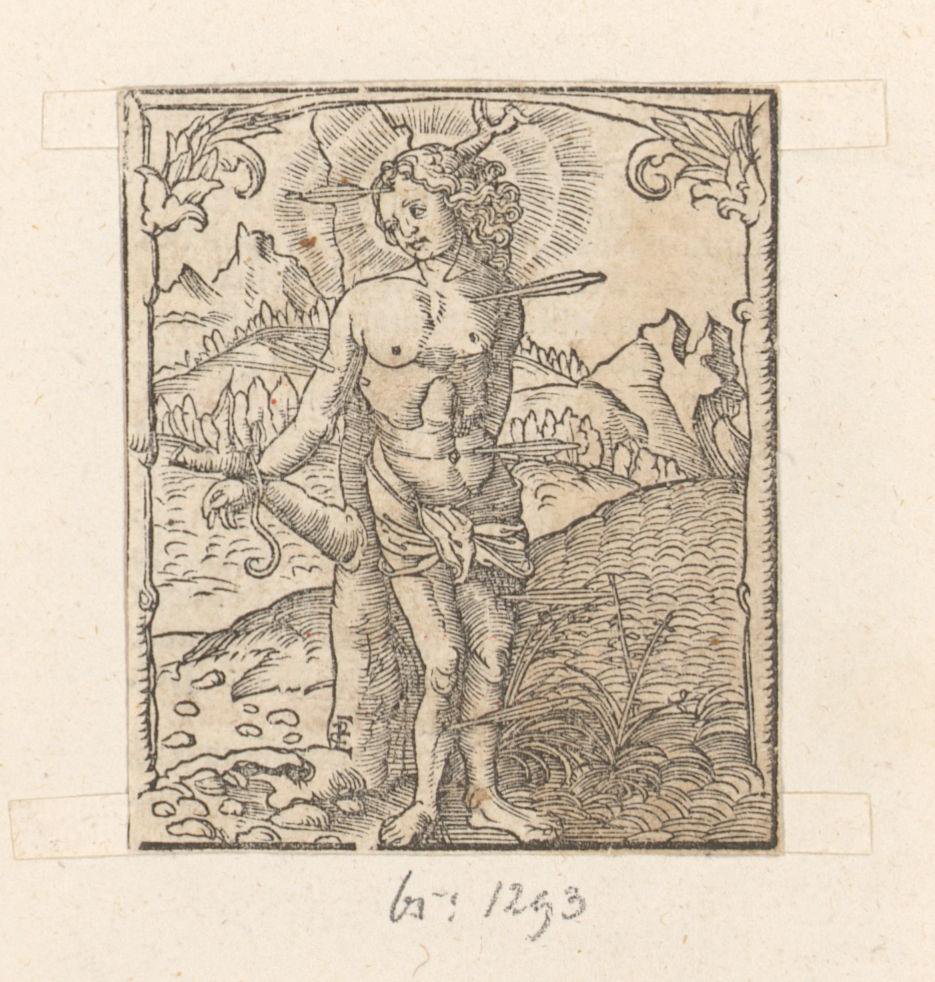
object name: book illustration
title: H. Sebastiaan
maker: erhard schön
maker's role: draughtsman, print maker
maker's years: 1491-1542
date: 1515-1517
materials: paper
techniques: woodcut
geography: nuremberg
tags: the martyr sebastian; possible attributes: arrow(s), bow, tree-trunk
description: De heilige Sebastiaan in een landschap vastgebonden aan een boom. Hij is met pijlen doorboord. Prent maakt deel uit van een album.